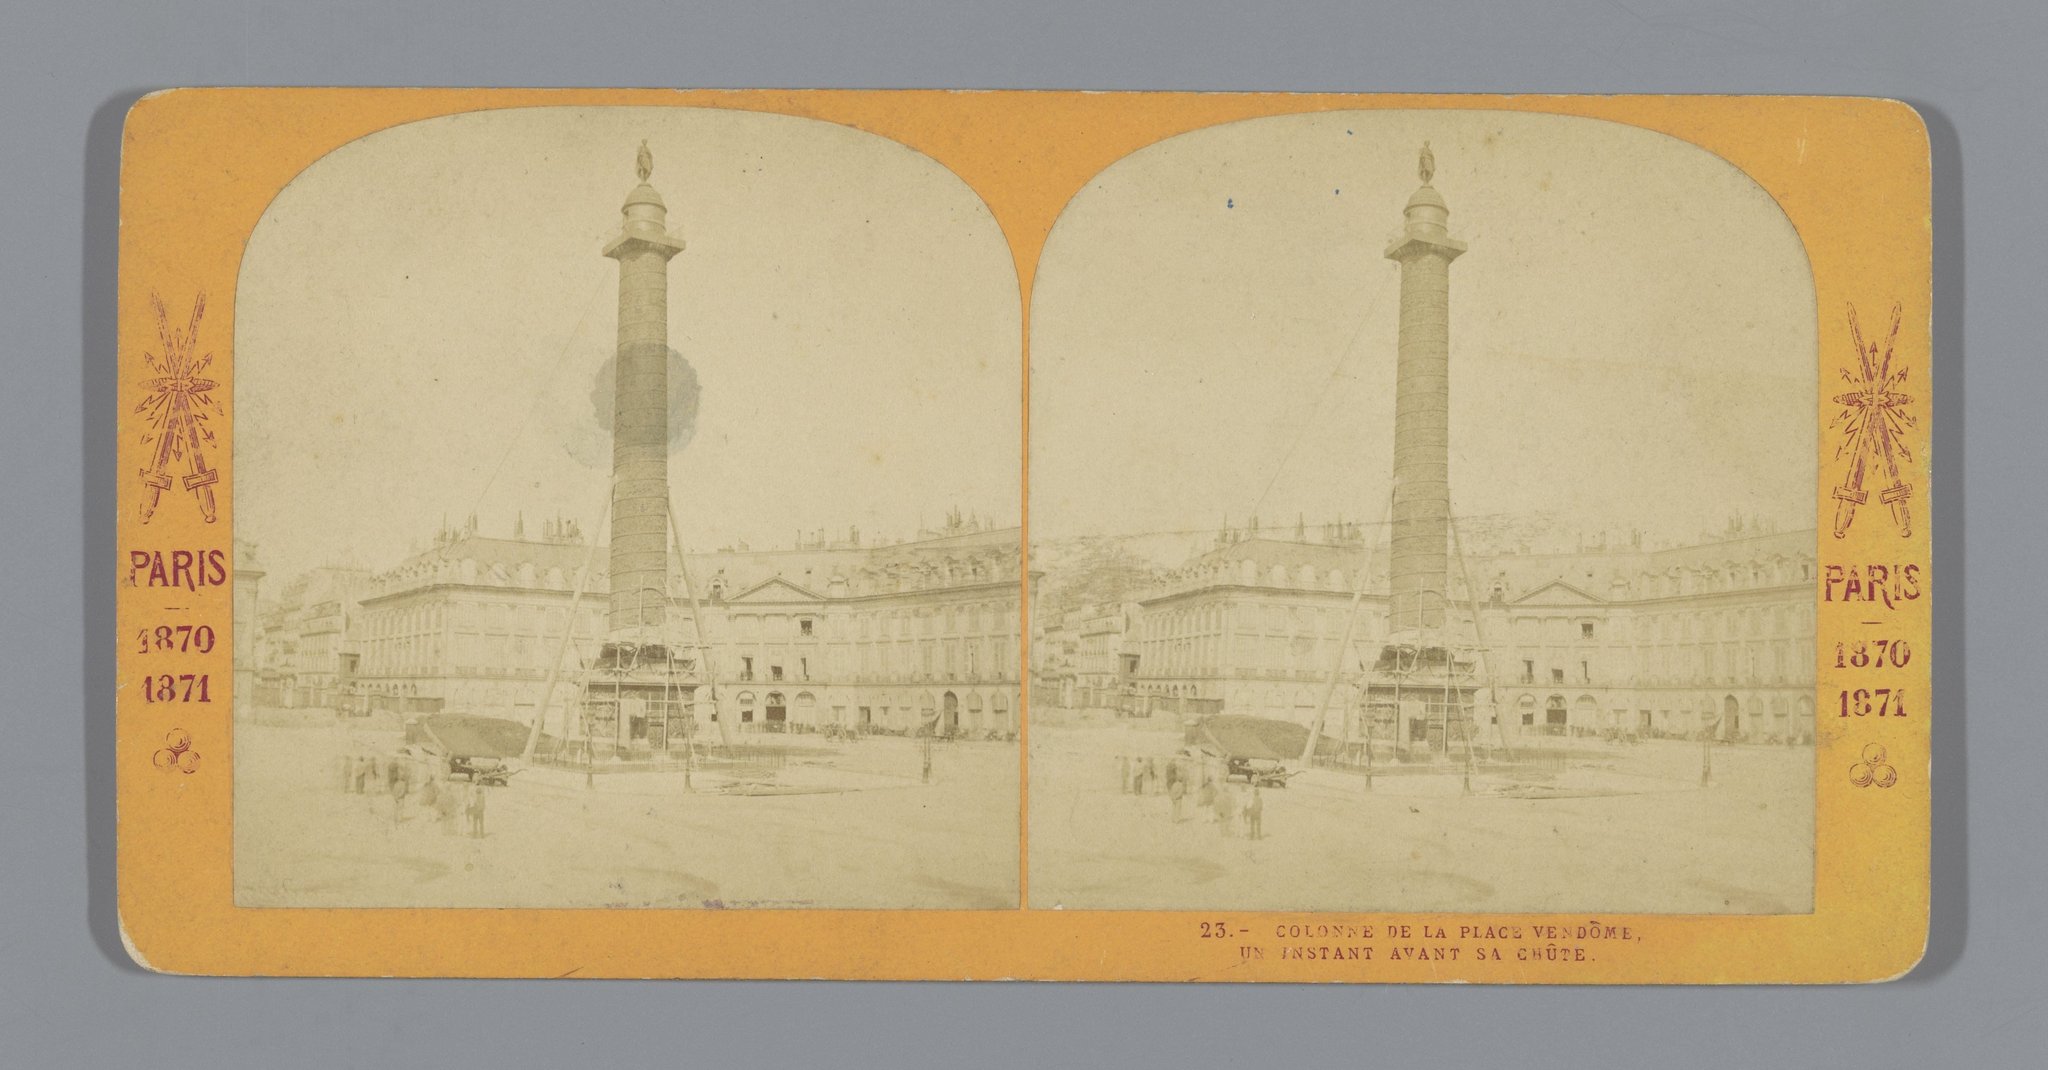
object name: stereograph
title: Paris - 1870 1871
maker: Anonymous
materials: cardboard, photographic support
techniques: albumen print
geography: place vendôme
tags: square, place, circus, etc., triumphal column with helical friezes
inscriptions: number: ‘23.’, inscription: ‘Parijs (Frankrijk)’